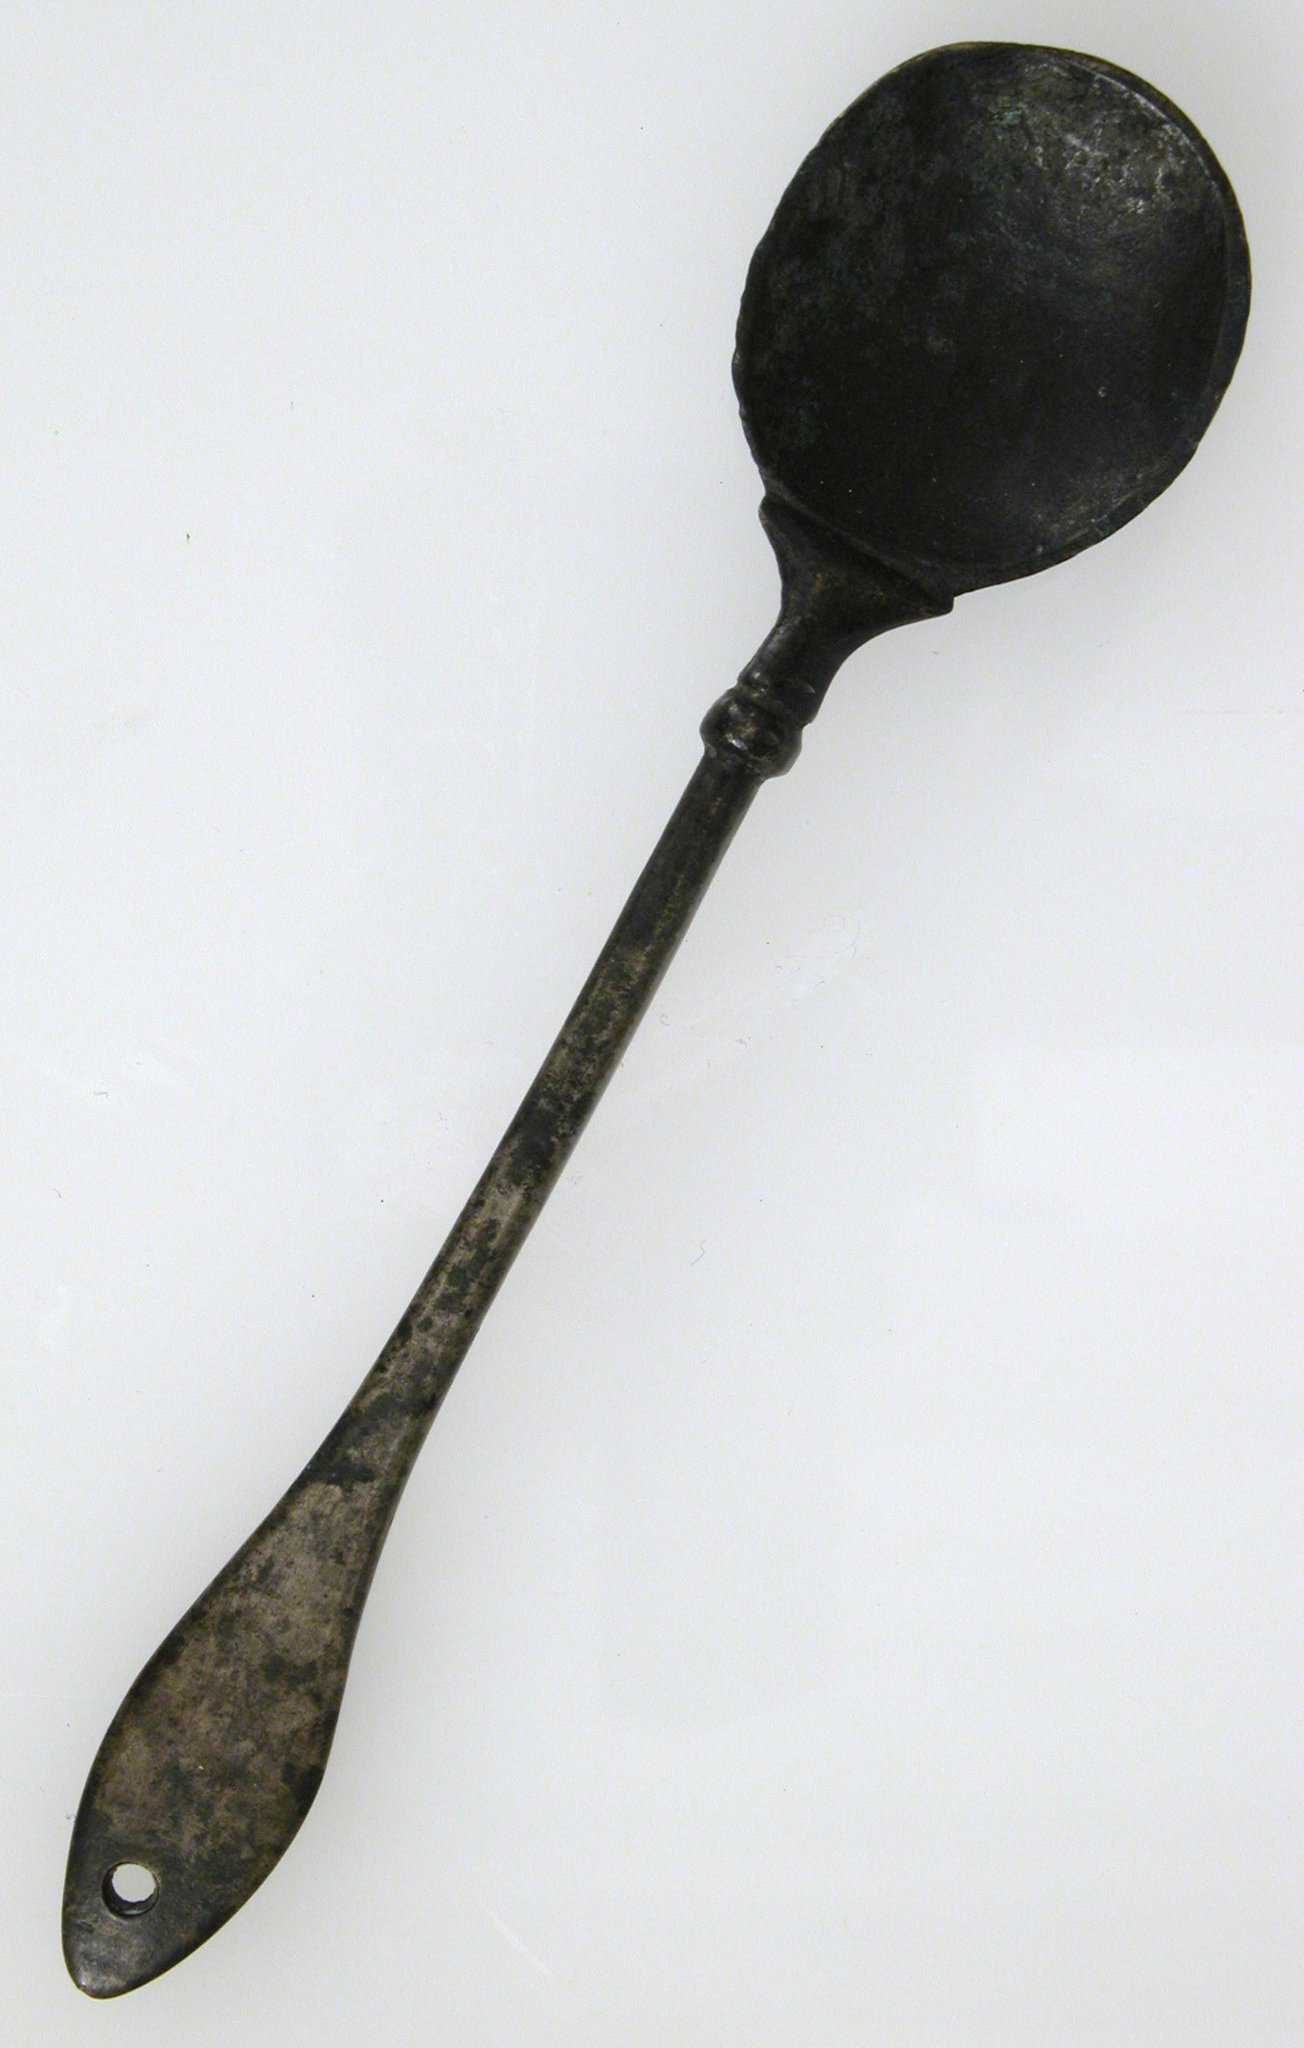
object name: spoon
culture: roman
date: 1-400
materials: bronze